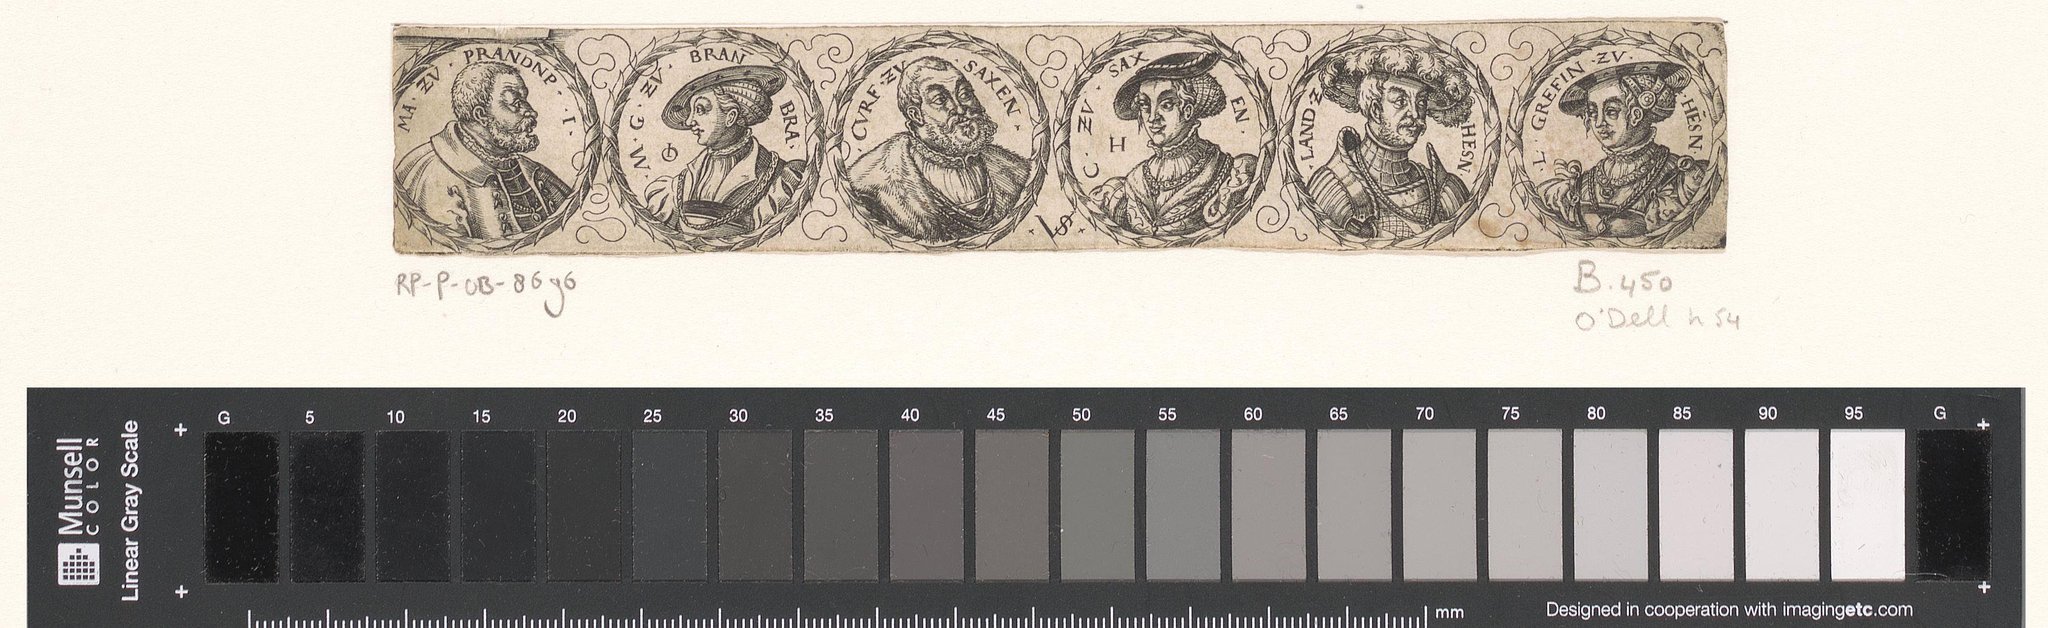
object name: print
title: Fries met zes bustes in lauwerkransen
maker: virgilius solis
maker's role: draughtsman, print maker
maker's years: 1514-1562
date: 1524-1562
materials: paper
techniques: engraving, etching, intaglio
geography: nuremberg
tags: chest, bust, ornament ~ medallion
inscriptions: collector's mark: Lugt 2228, number: ‘14’